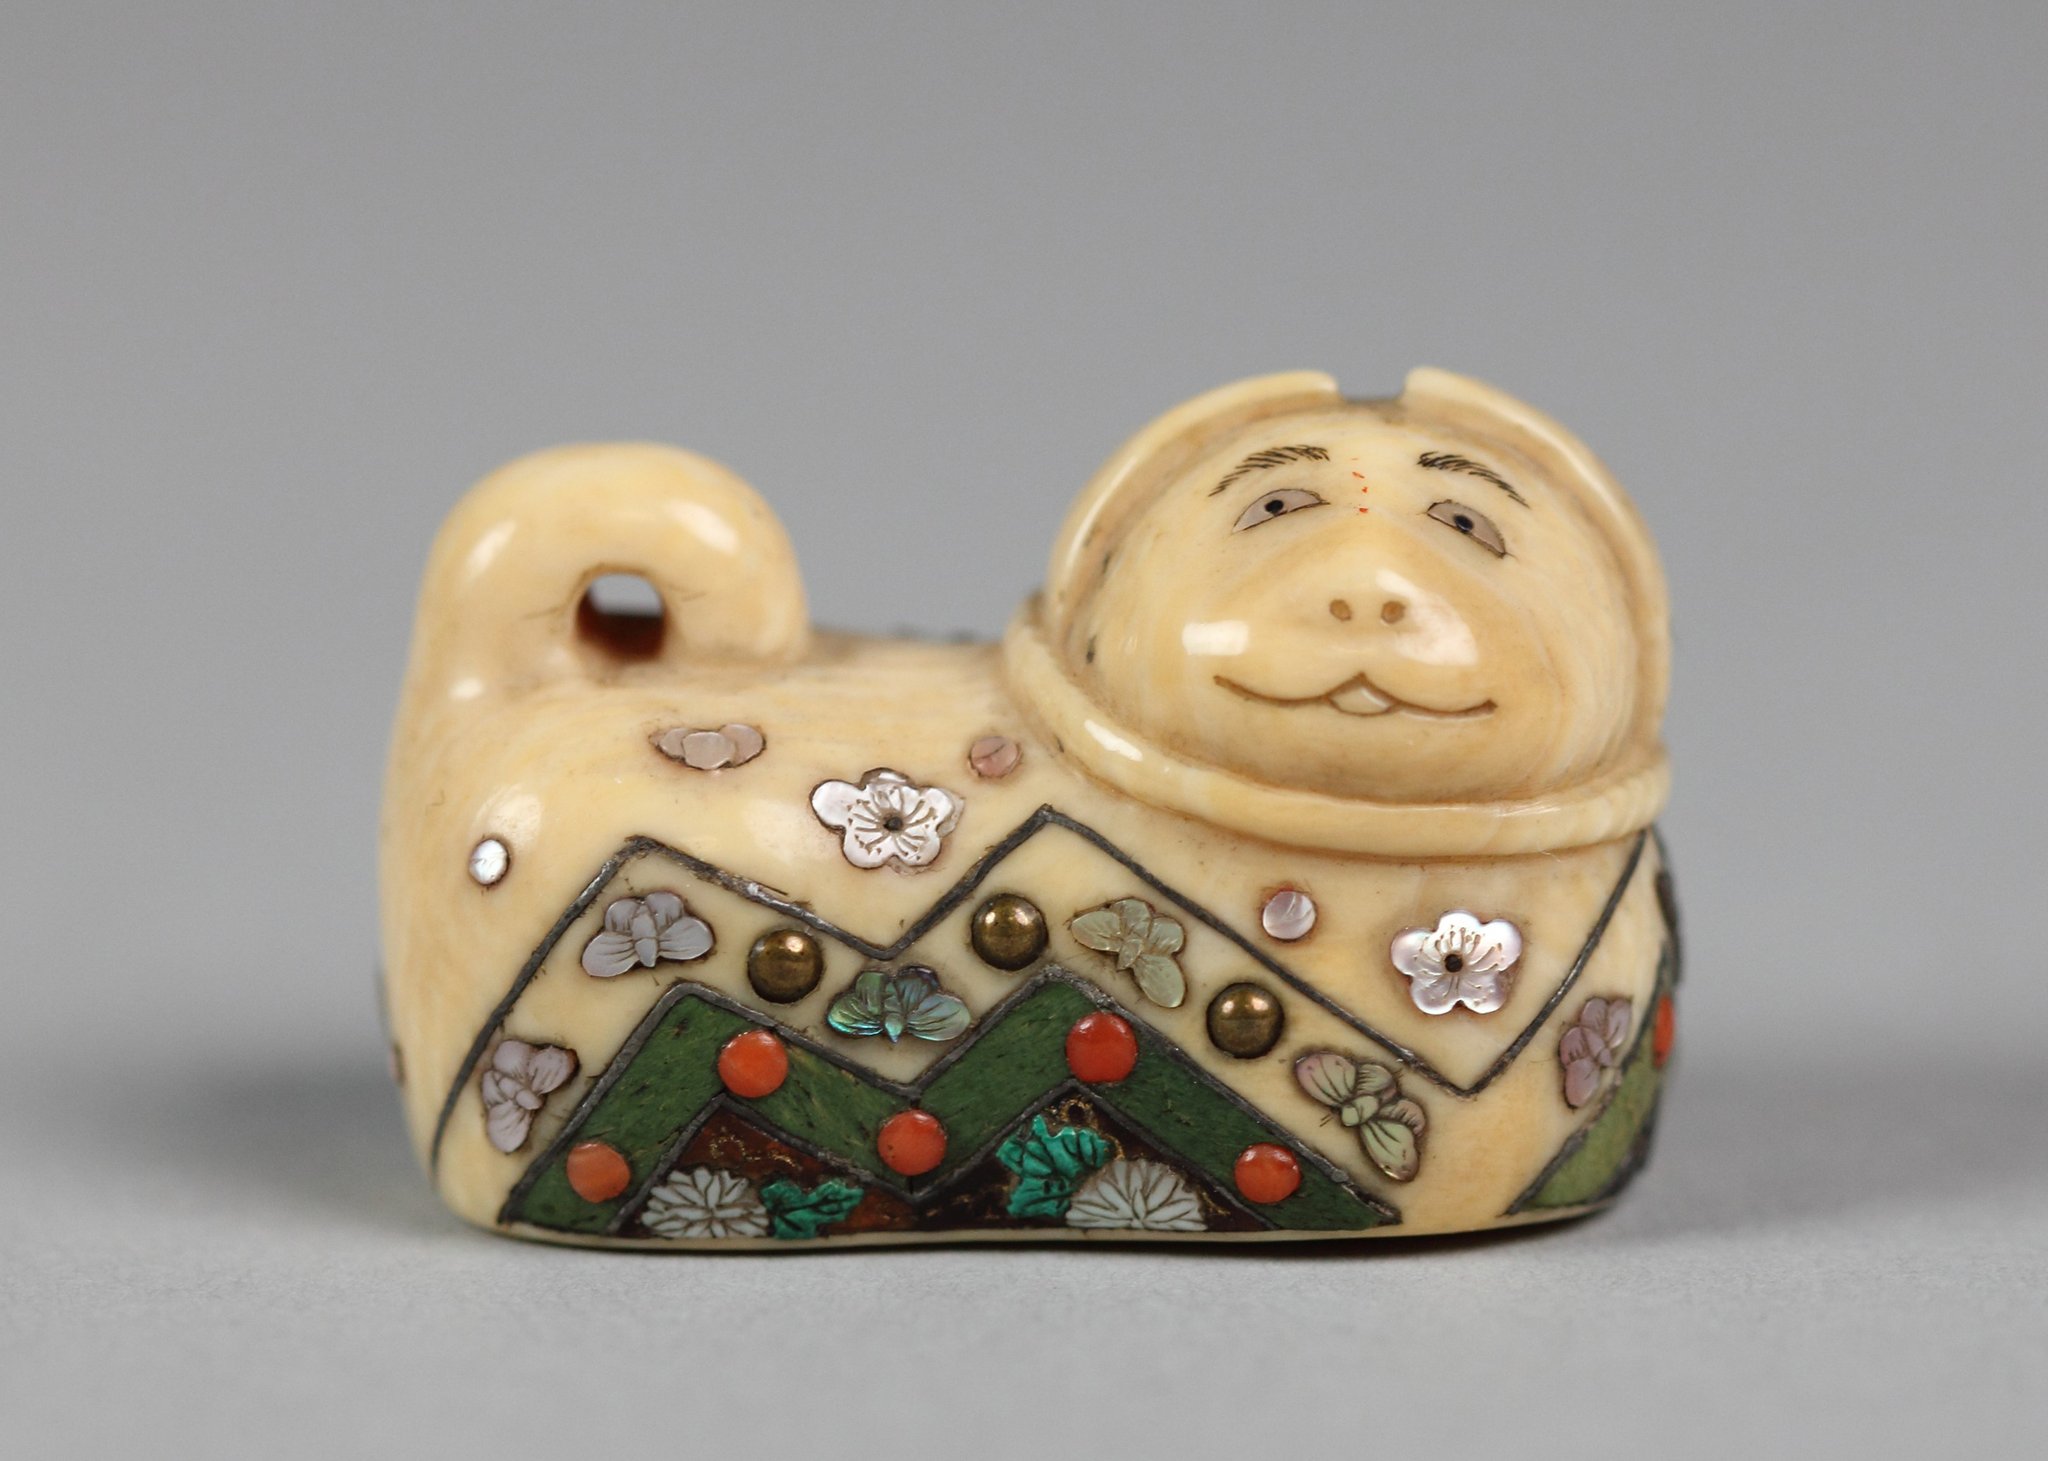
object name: netsuke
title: Dog Amulet (Inu Hariko)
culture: japanese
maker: shitayama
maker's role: artist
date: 1834-1866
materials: ivory, metal, mother of pearl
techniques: enamel, inlay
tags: dogs